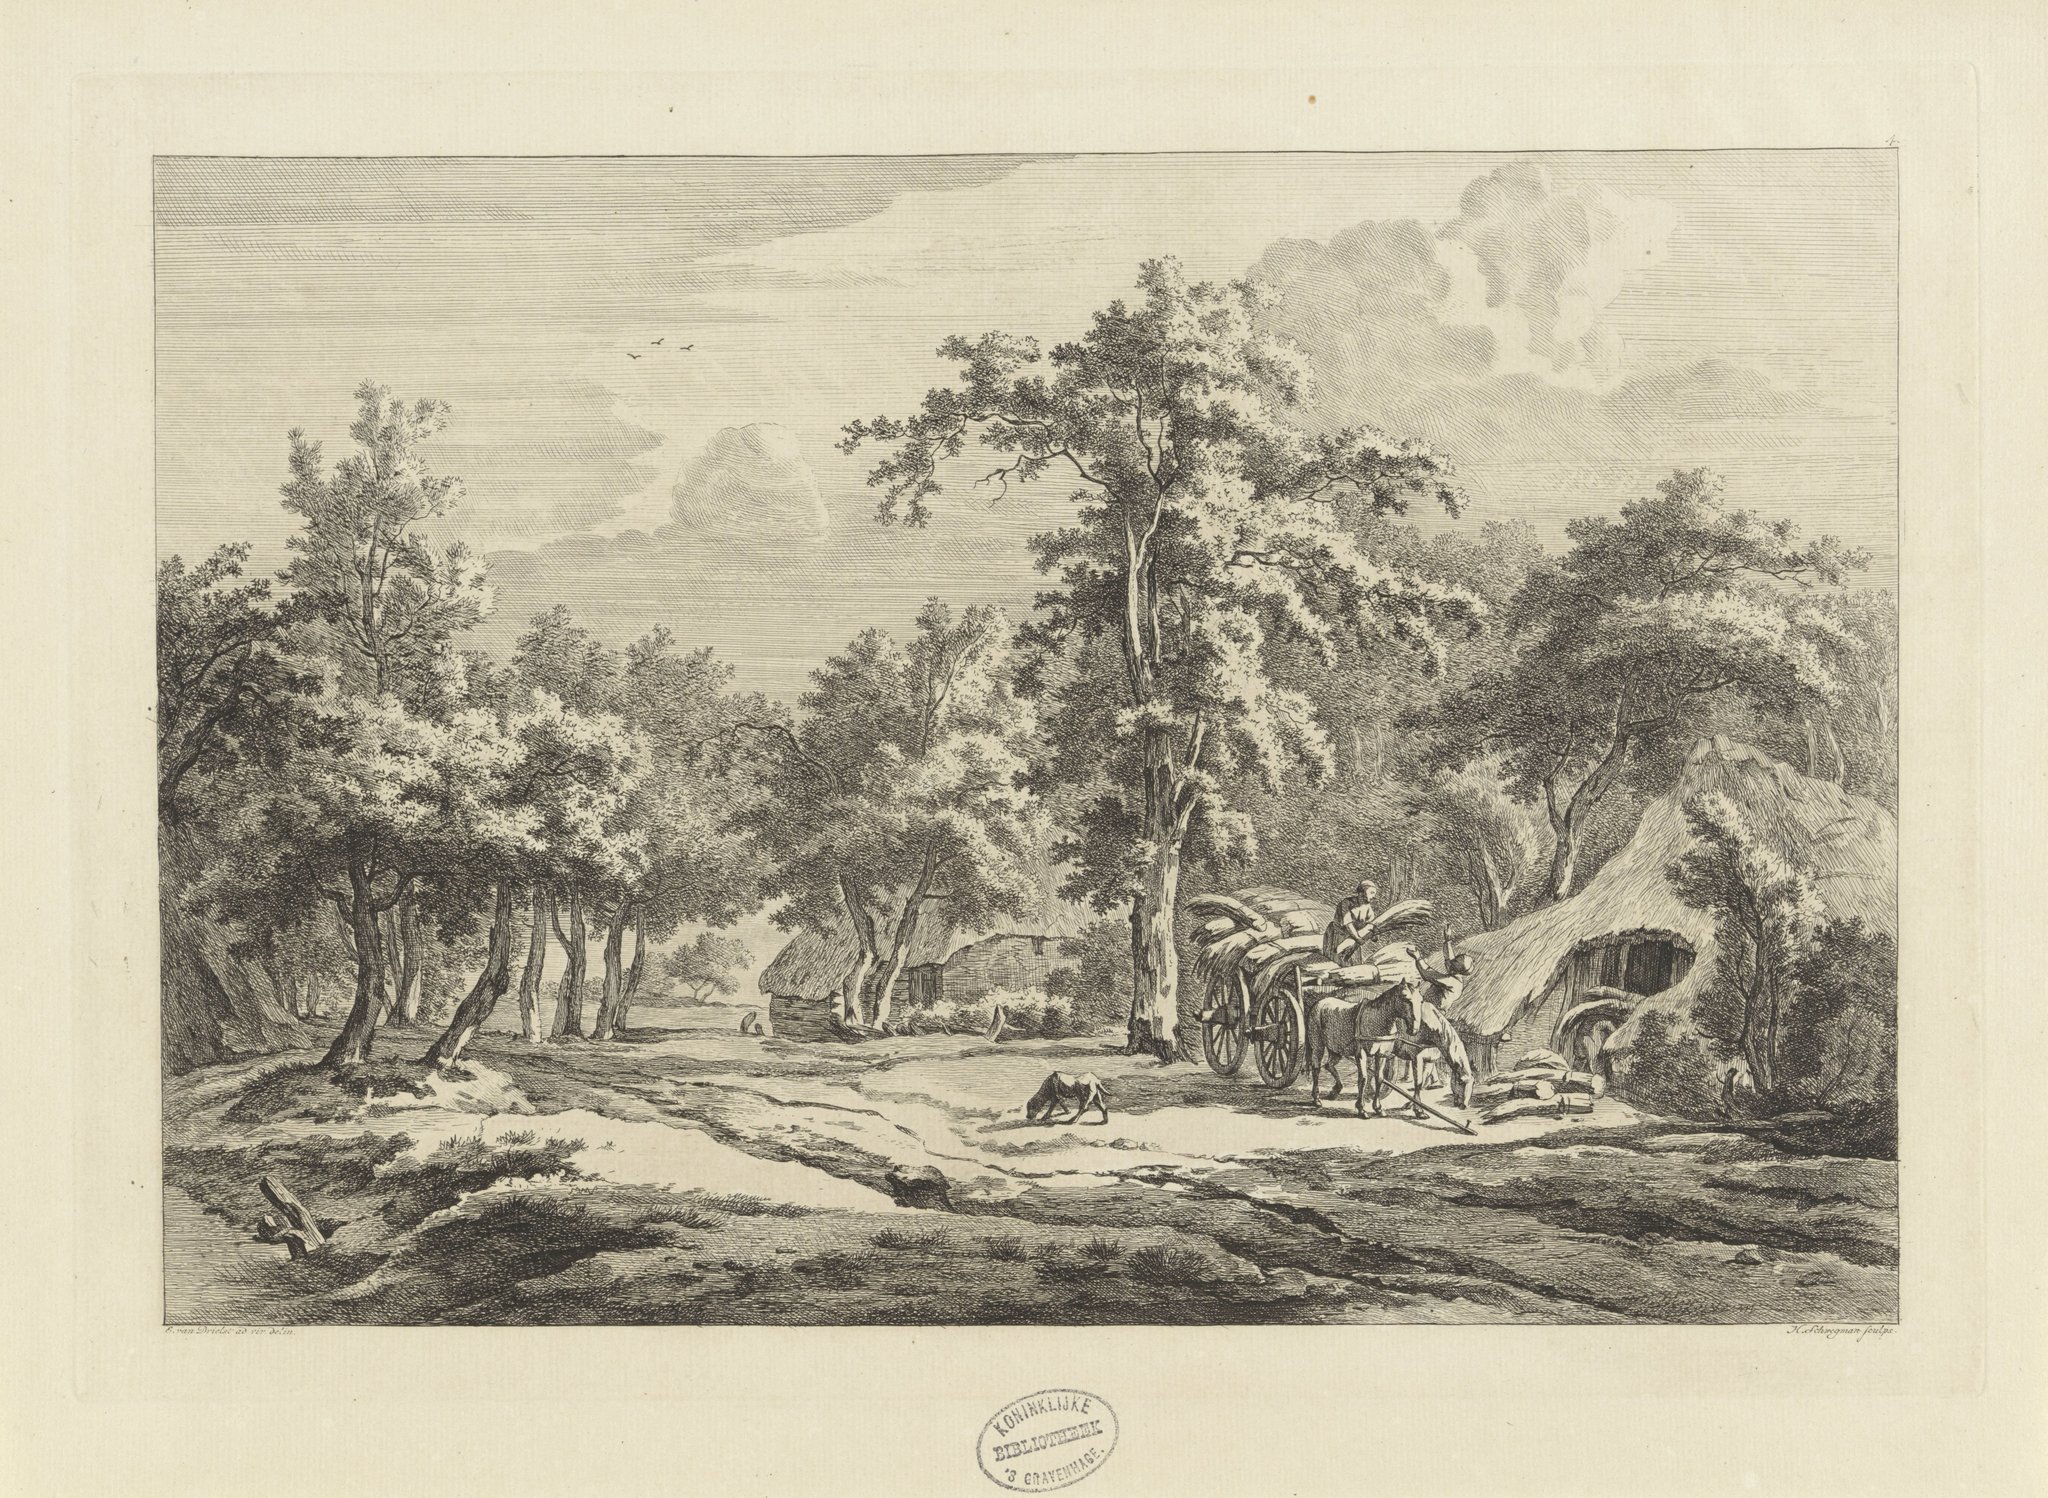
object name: print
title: Landschap te Westerbork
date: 1771-1816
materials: paper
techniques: engraving, etching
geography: westerbork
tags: hay-wagon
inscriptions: collector's mark: Lugt 1097, collector's mark: Lugt 2228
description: Twee boerderijen in Westerbork, Drenthe. Een man en een vrouw laden bundels stro van een kar.